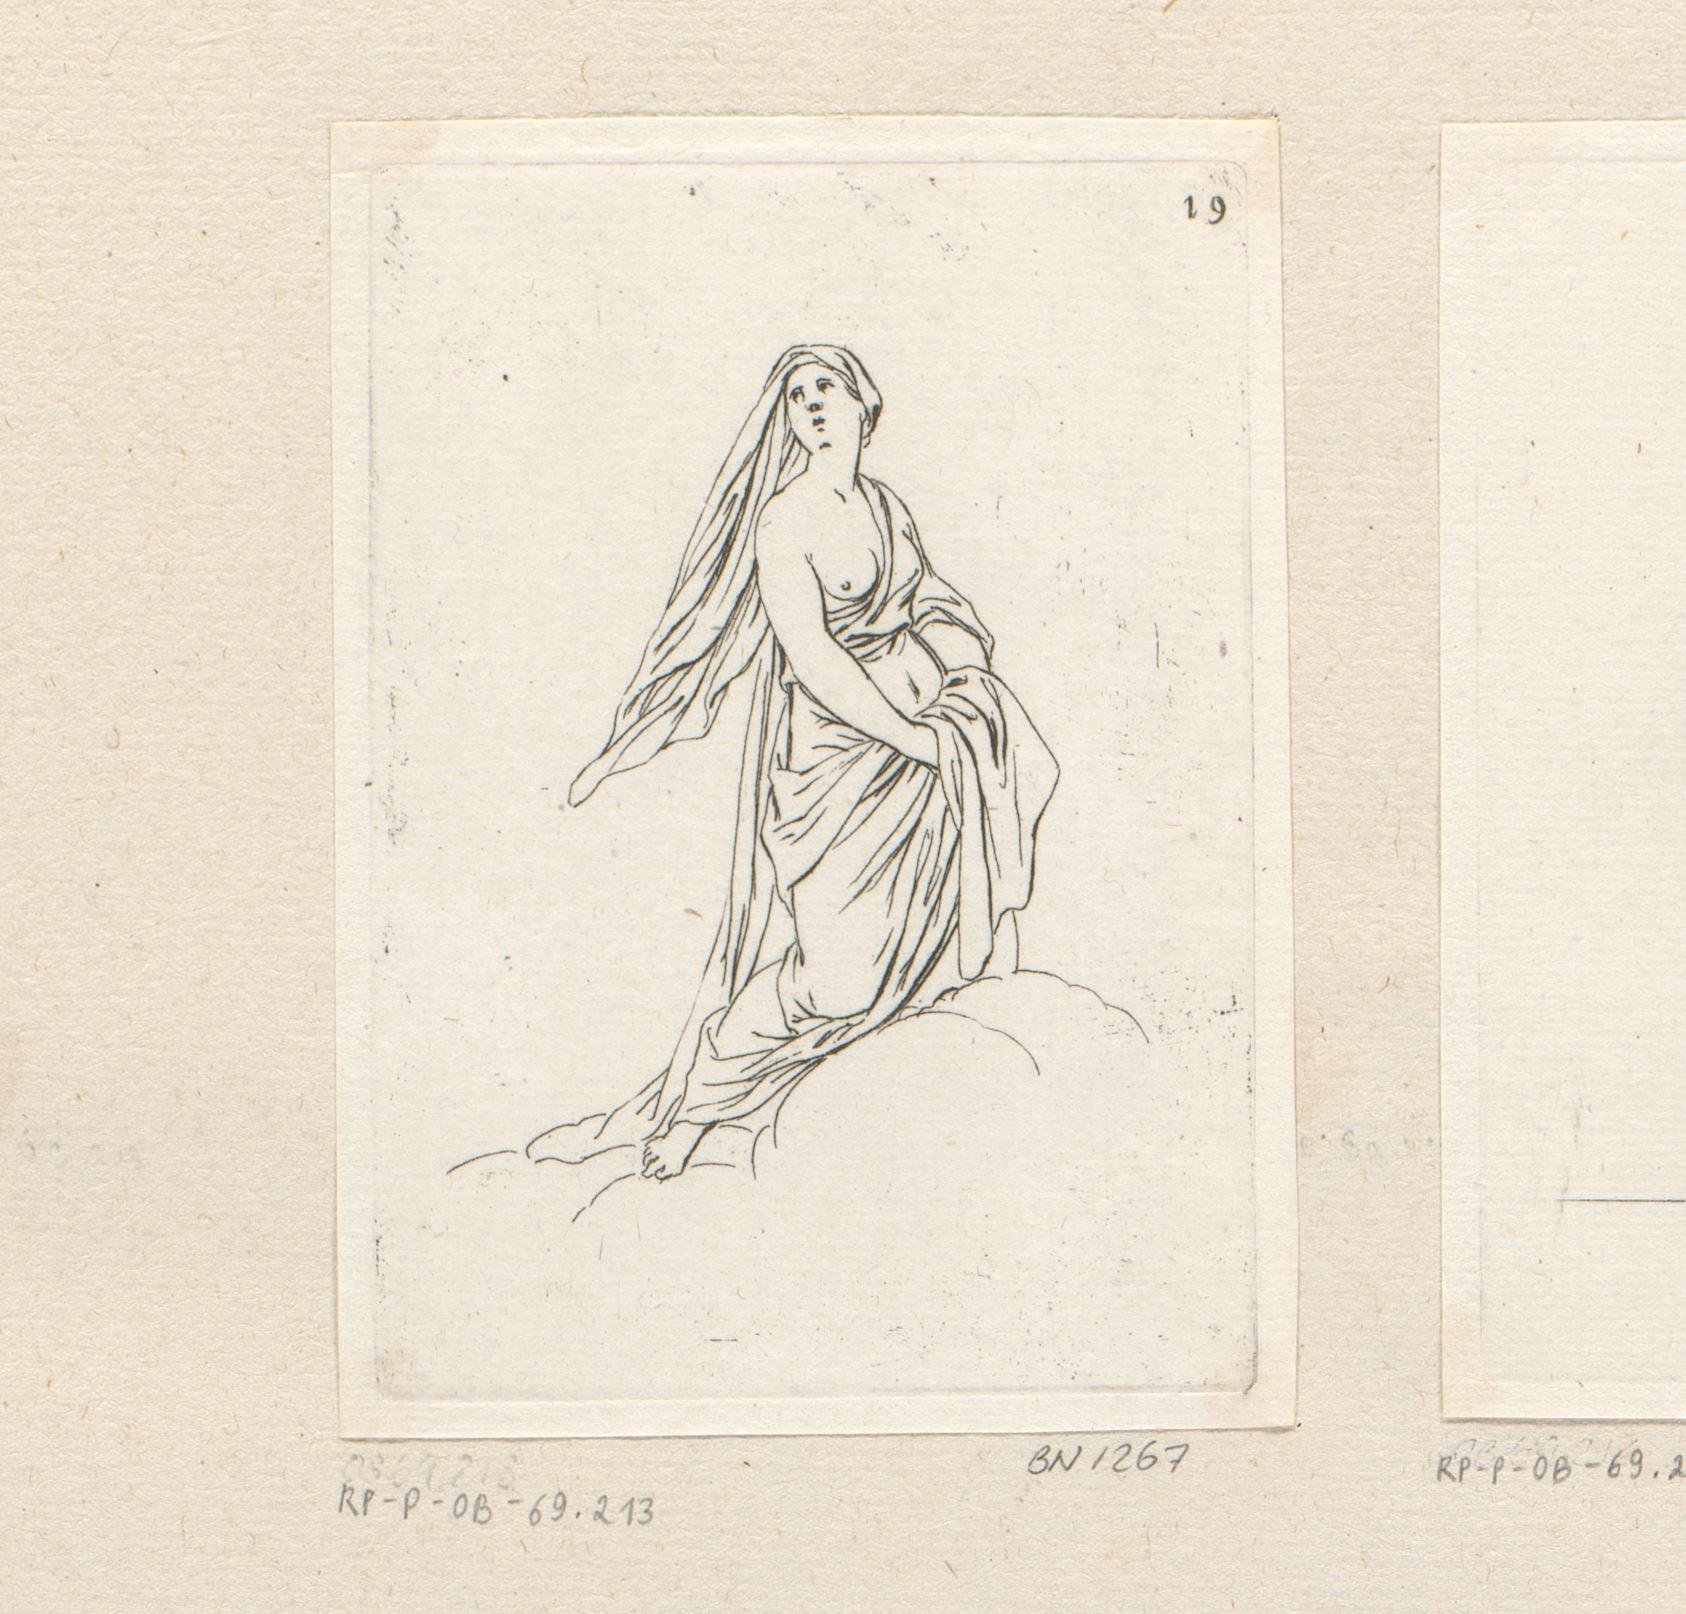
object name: print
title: Geknielde vrouw met ontblote borst op wolk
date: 1706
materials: paper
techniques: etching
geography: paris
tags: adult woman